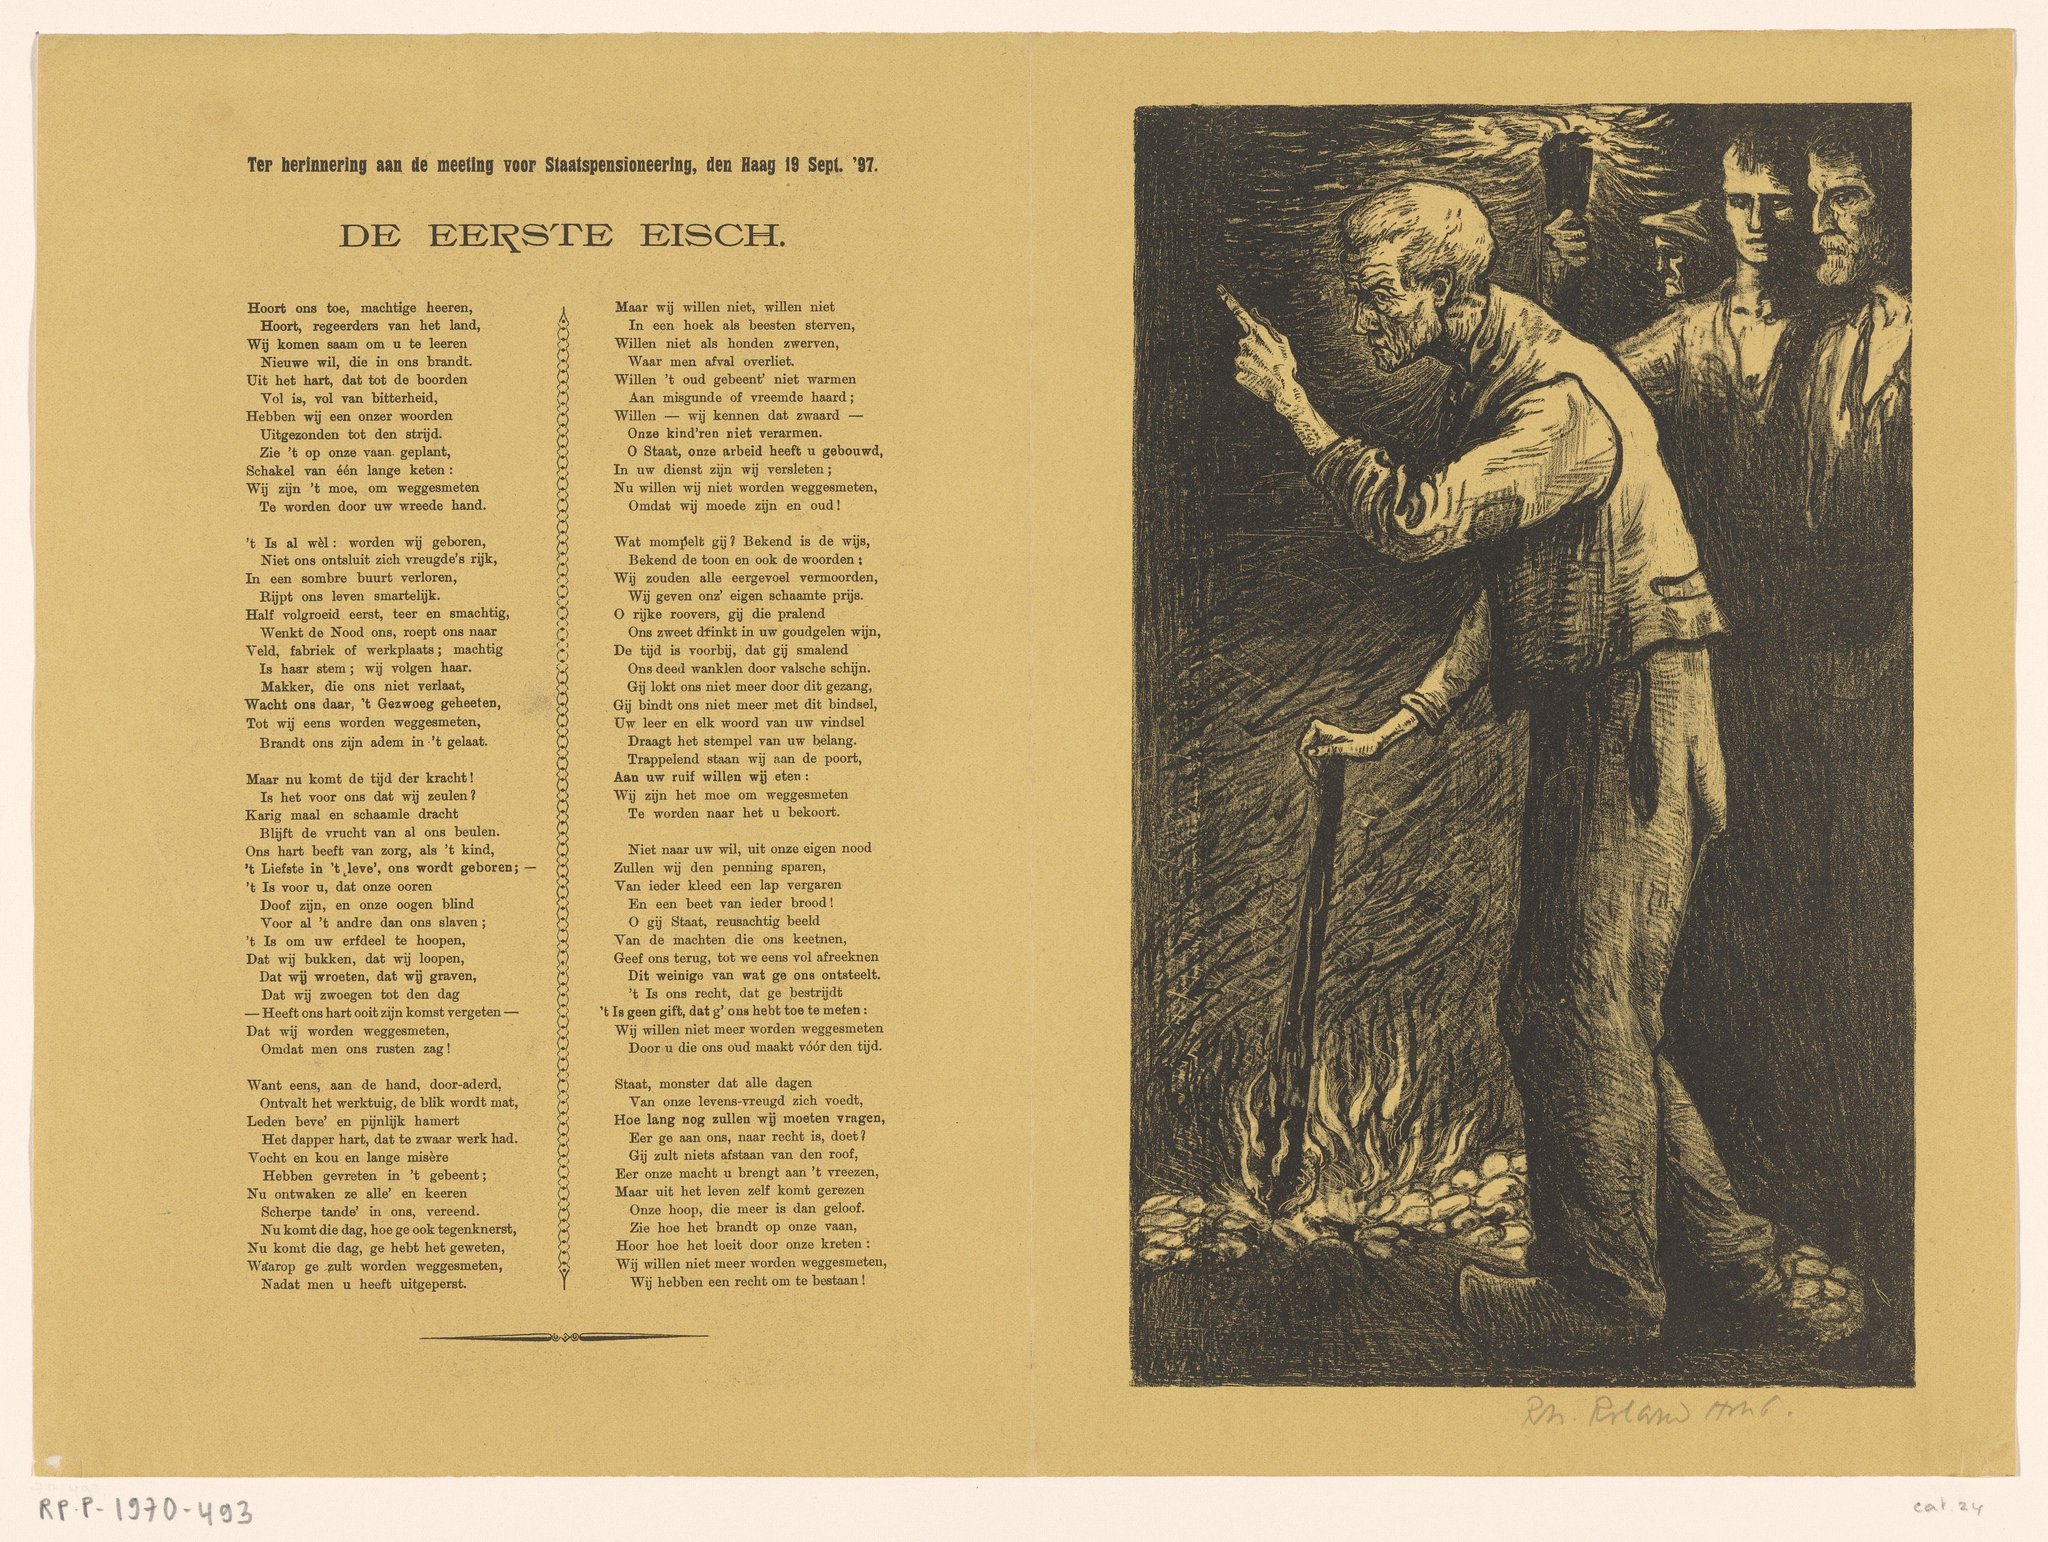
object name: print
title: De eerste eisch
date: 1898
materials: paper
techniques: lithograph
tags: torch, working class, labourers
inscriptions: collector's mark: Lugt 2228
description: Richard Roland Holst vervaardigde deze prent bij het gedicht 'De eerste eisch' van Henriëtte Roland Holst-van der Schalk, dat zij schreef 'ter herinnering aan de meeting voor Staatspensioneering, den Haag 19 Sept. '97.'